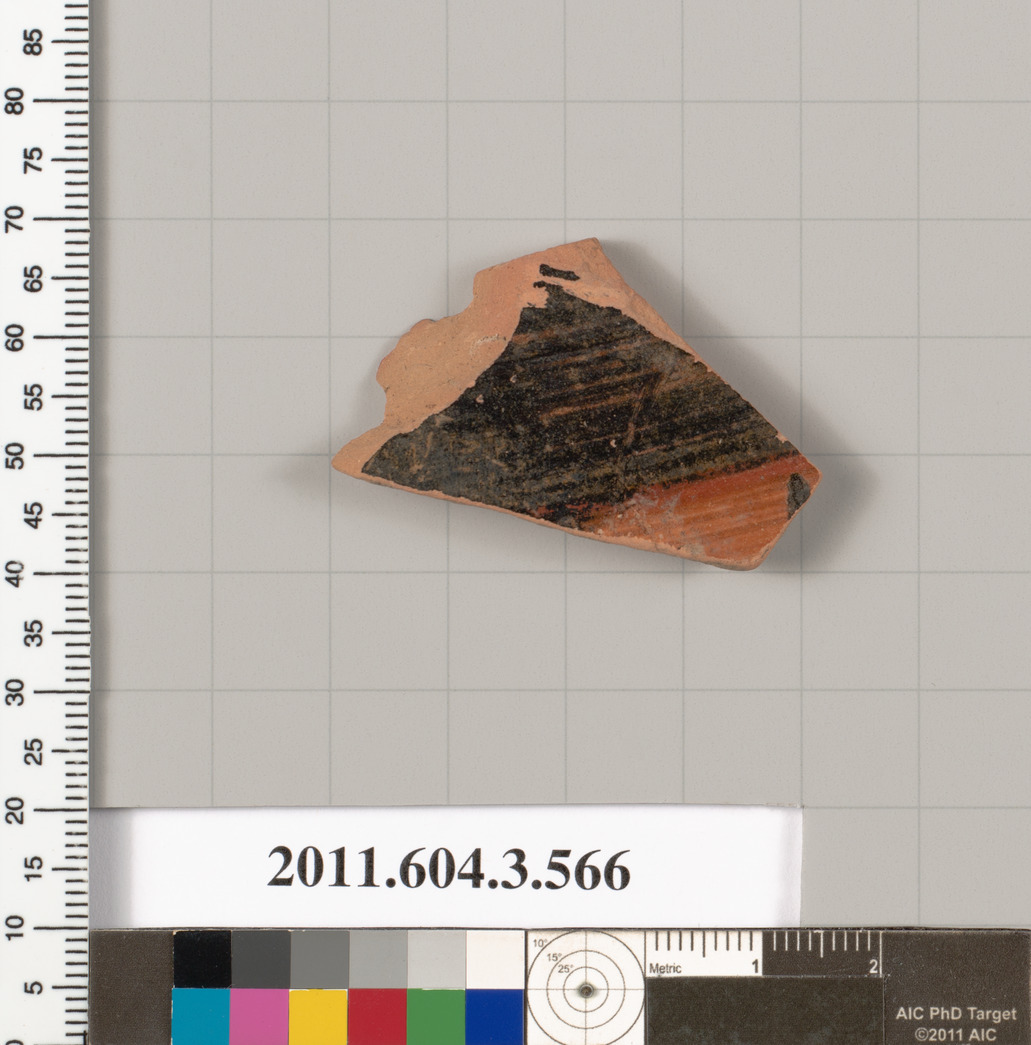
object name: column krater fragment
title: Terracotta fragment of a column-krater (bowl for mixing wine and water)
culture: greek, attic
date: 600-401 BCE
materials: terracotta